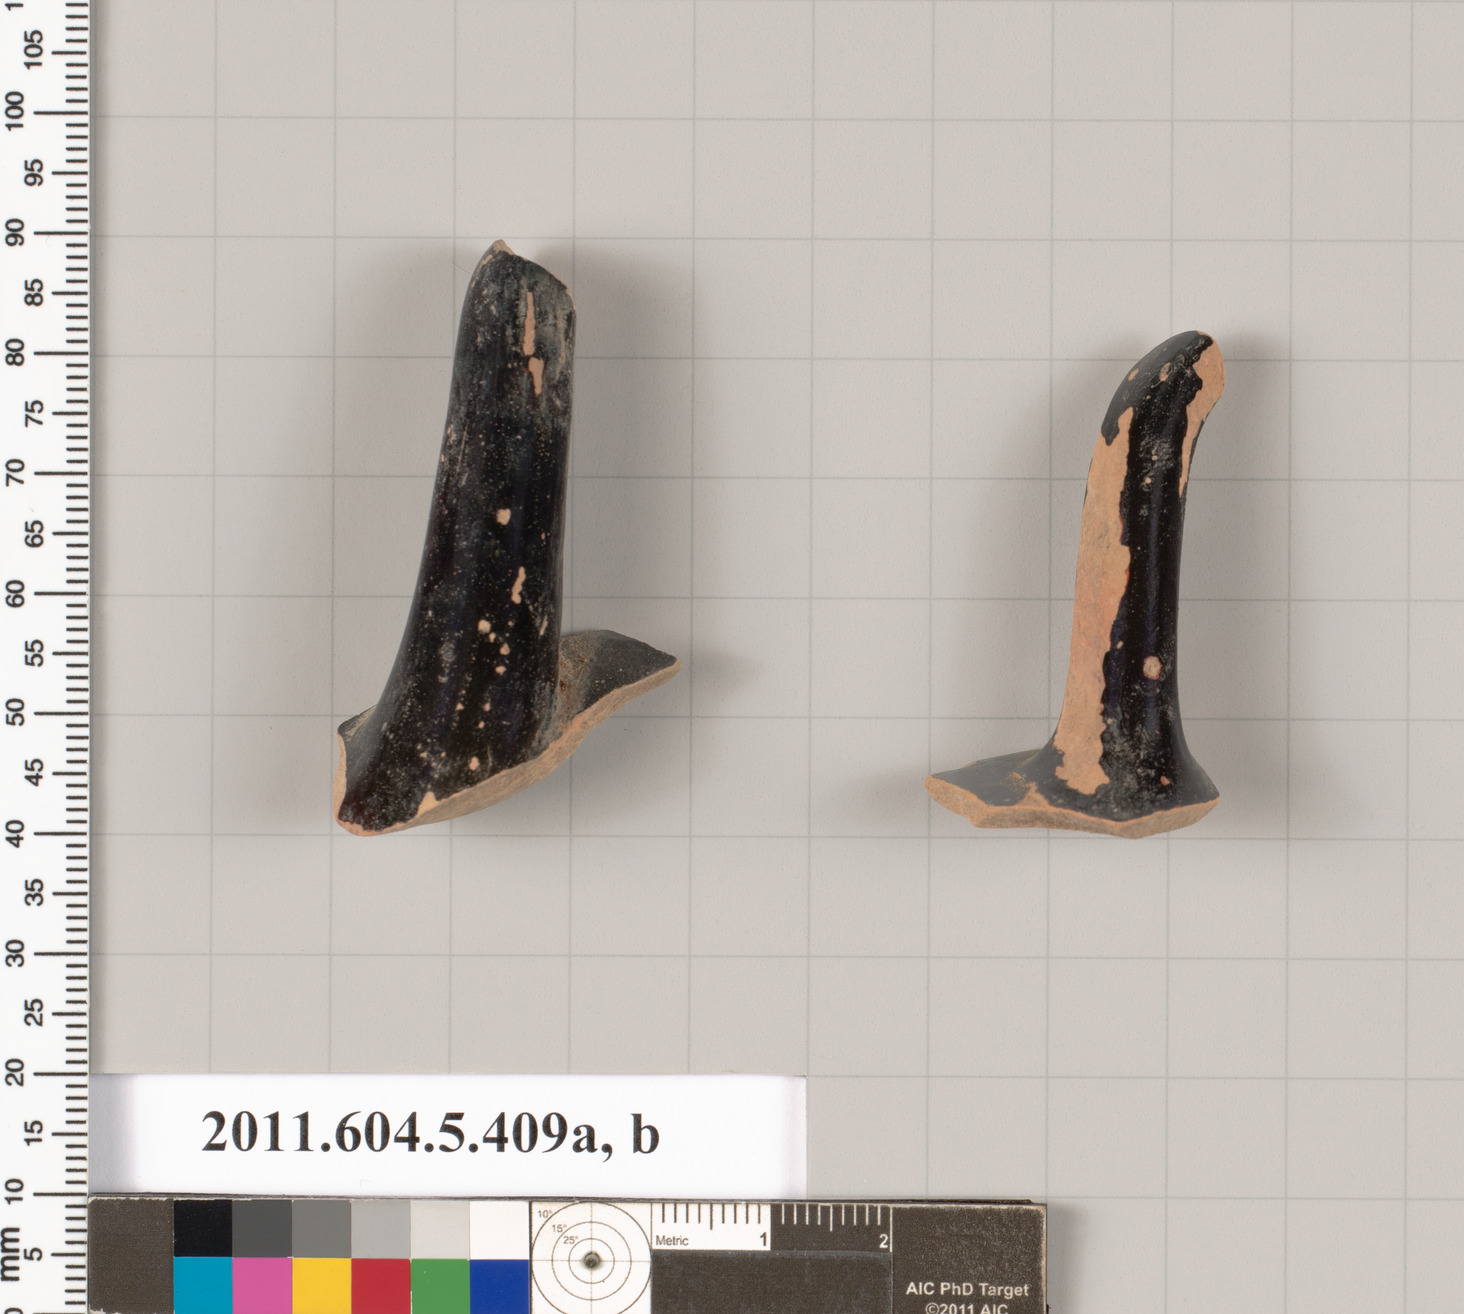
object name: kylix fragment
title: Terracotta fragments of kylikes (drinking cups)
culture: greek, attic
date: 600-401 BCE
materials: terracotta